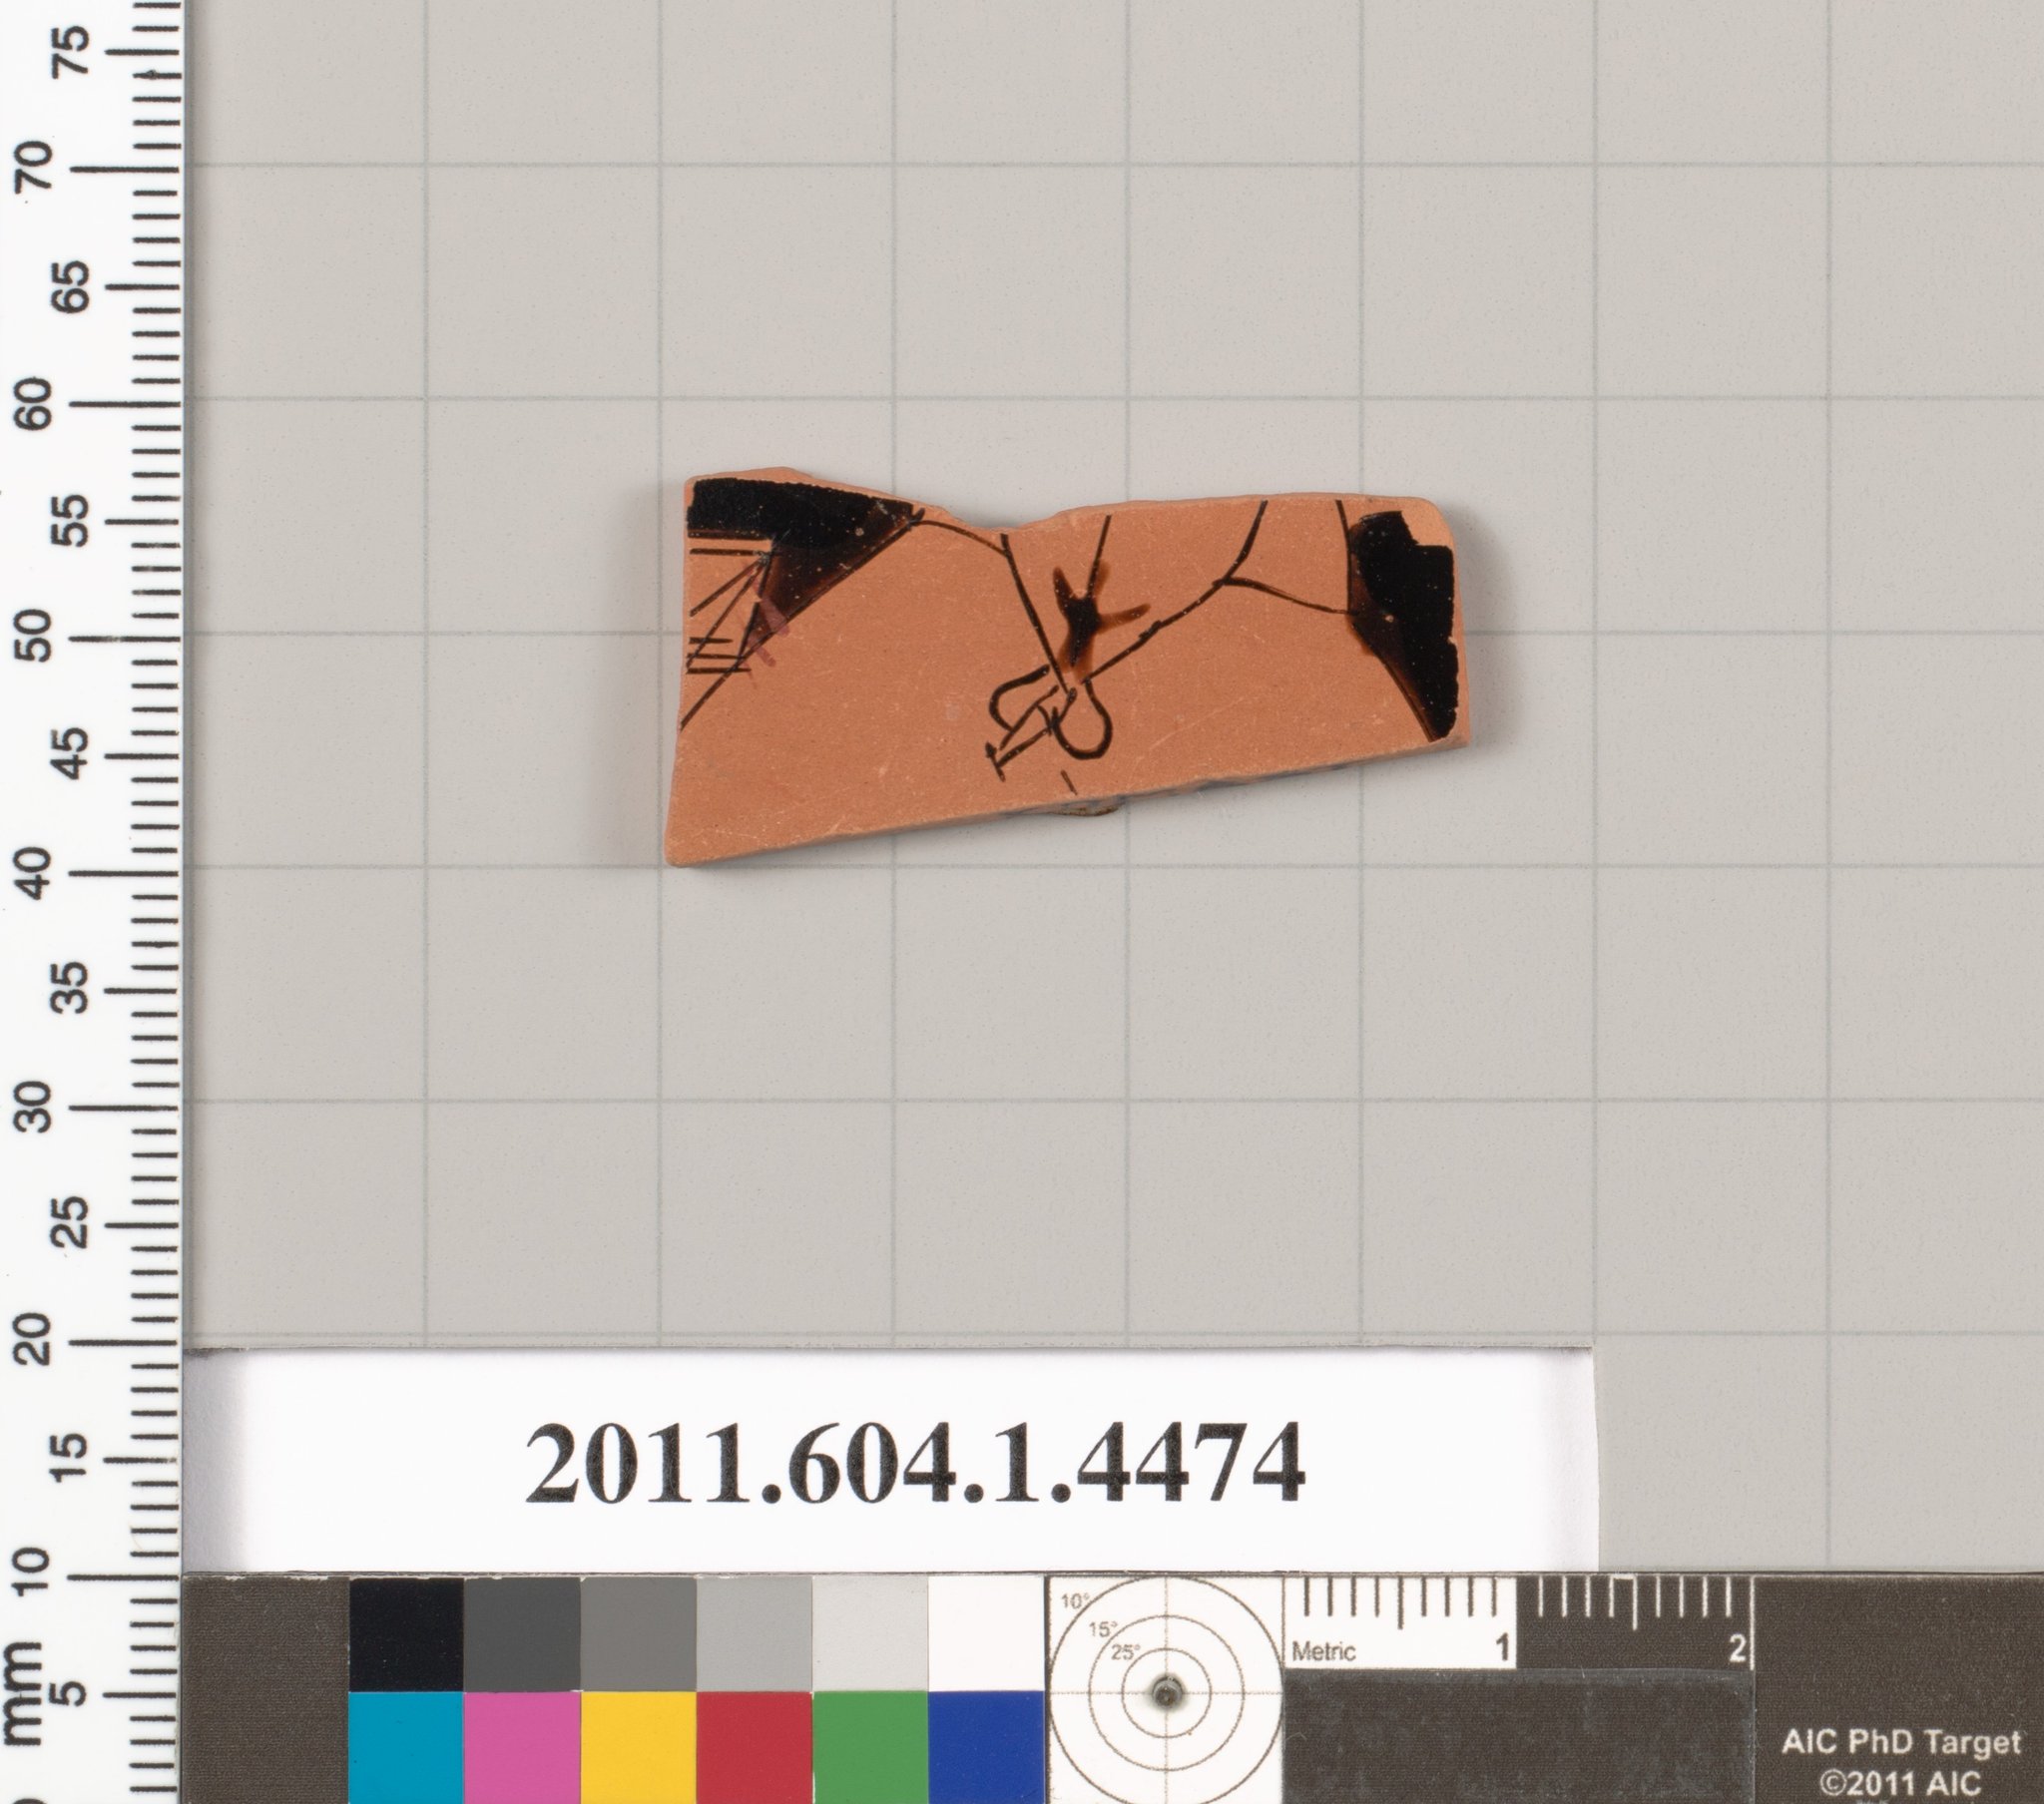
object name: kylix fragment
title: Terracotta fragment of a kylix (drinking cup)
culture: greek, attic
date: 490-480 BCE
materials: terracotta